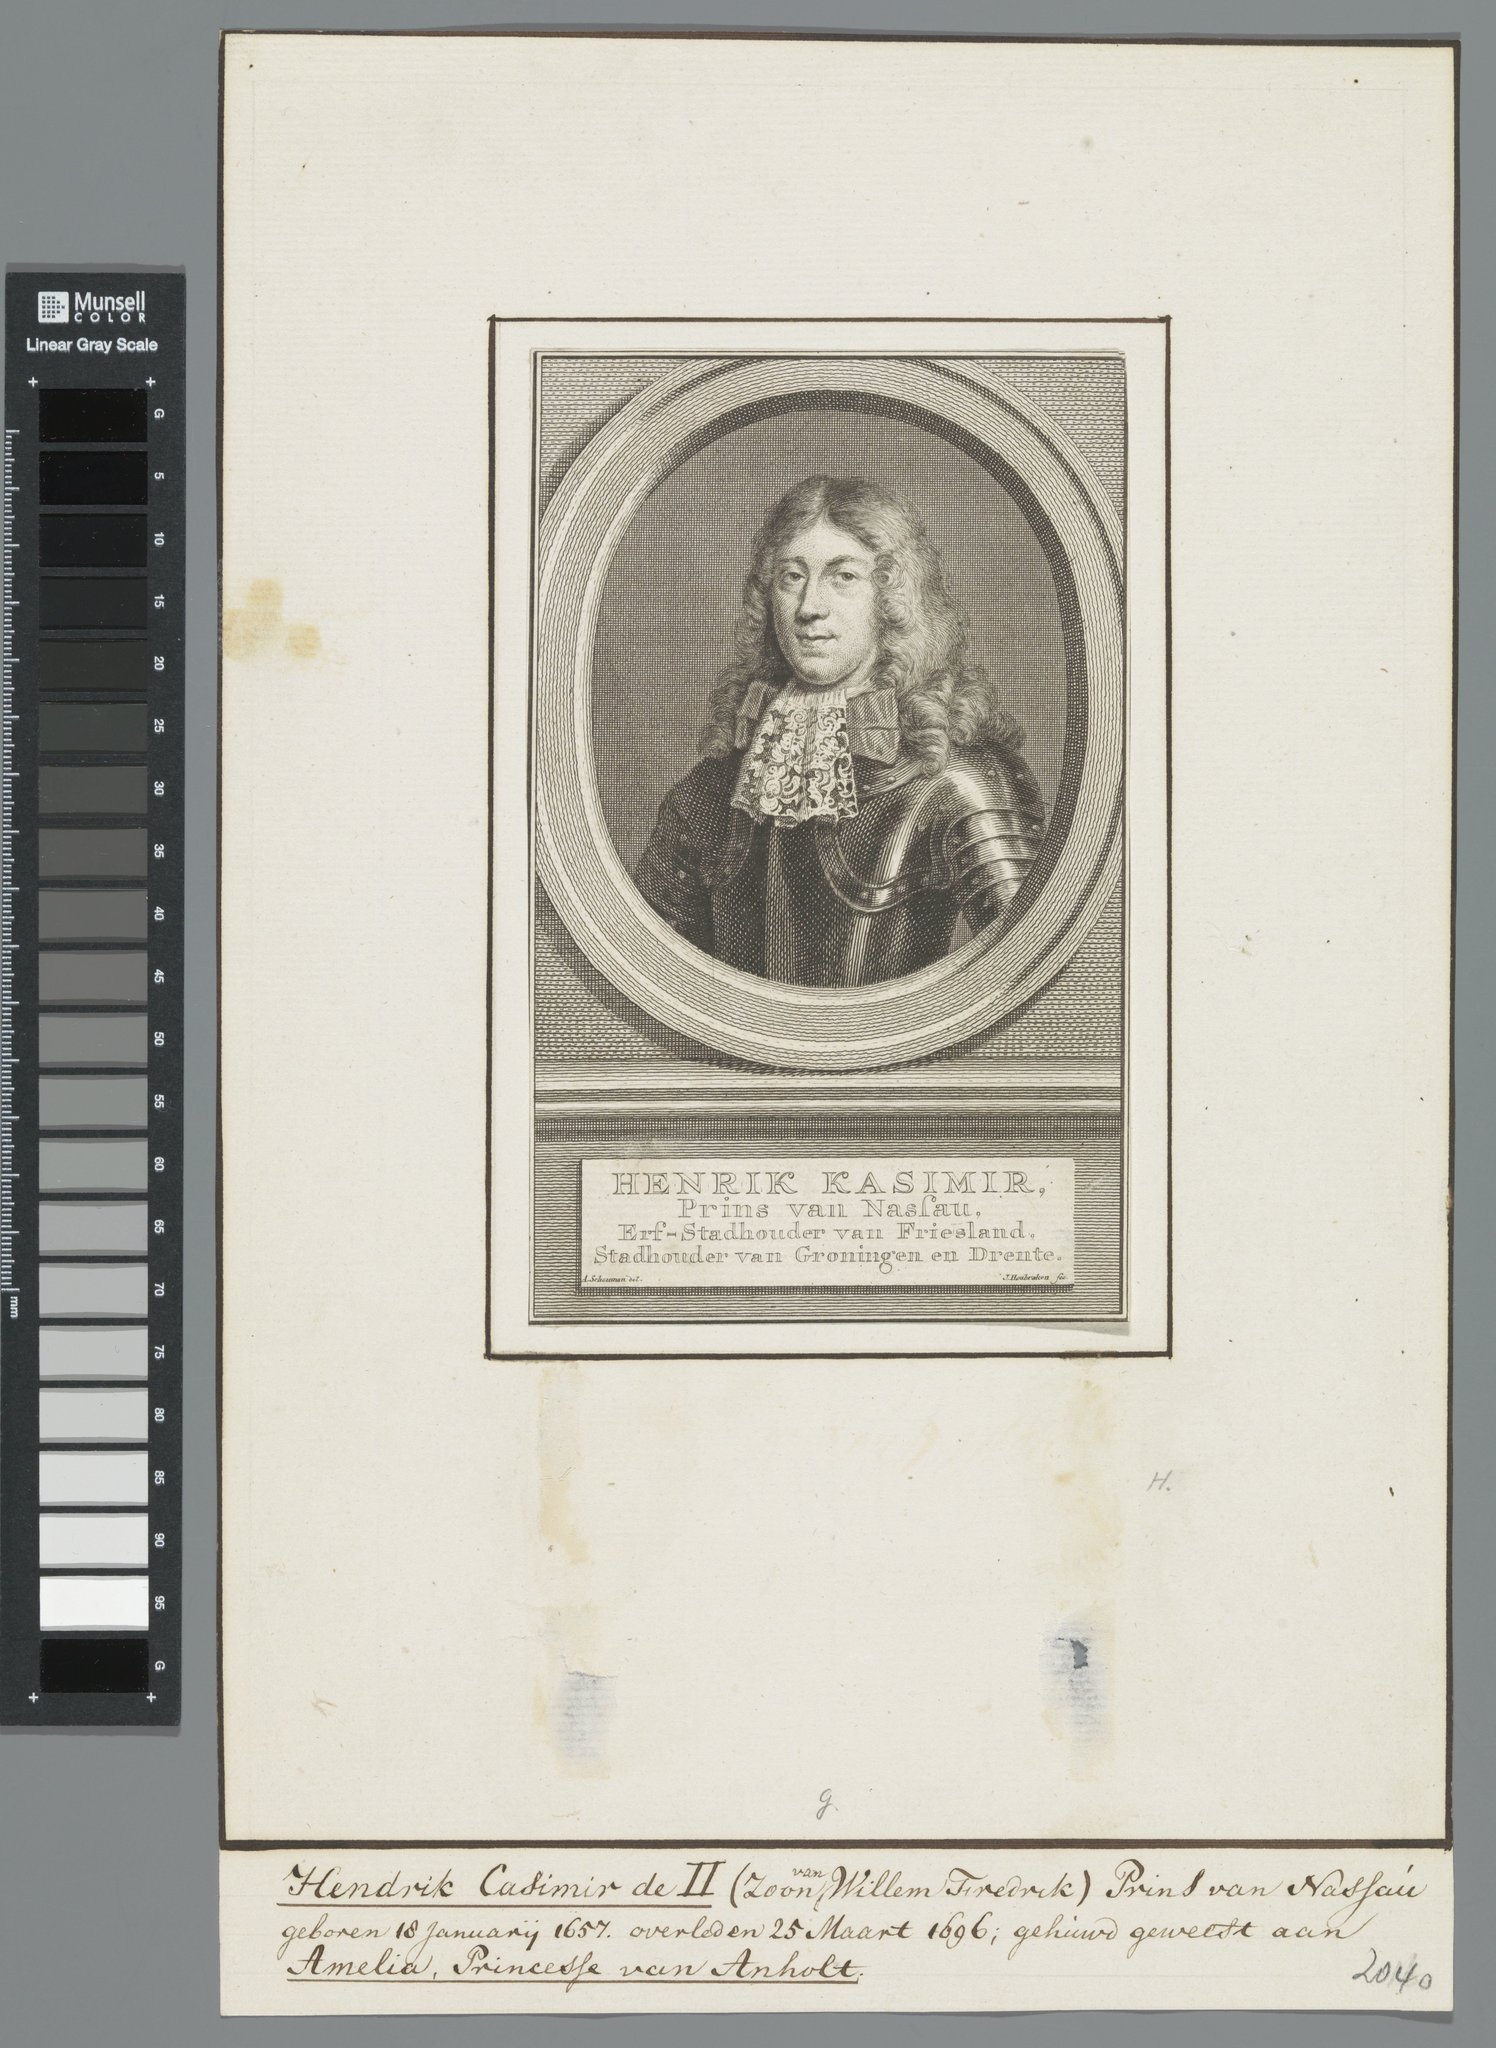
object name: print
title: Portret van Hendrik Casimir II, graaf van Nassau-Dietz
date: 1749-1759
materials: paper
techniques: engraving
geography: amsterdam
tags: the hague, hendrik casimir ii graaf van nassau-dietz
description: De hier vermelde titel verwijst naar de hoogst verkregen titel van de geportretteerde, niet per se naar de titel die de geportretteerde op deze voorstelling draagt. Prent uit: Wagenaar, Jan. Vaderlandsche historie. Amsterdam: Isaak Tirion, 1749-1759.